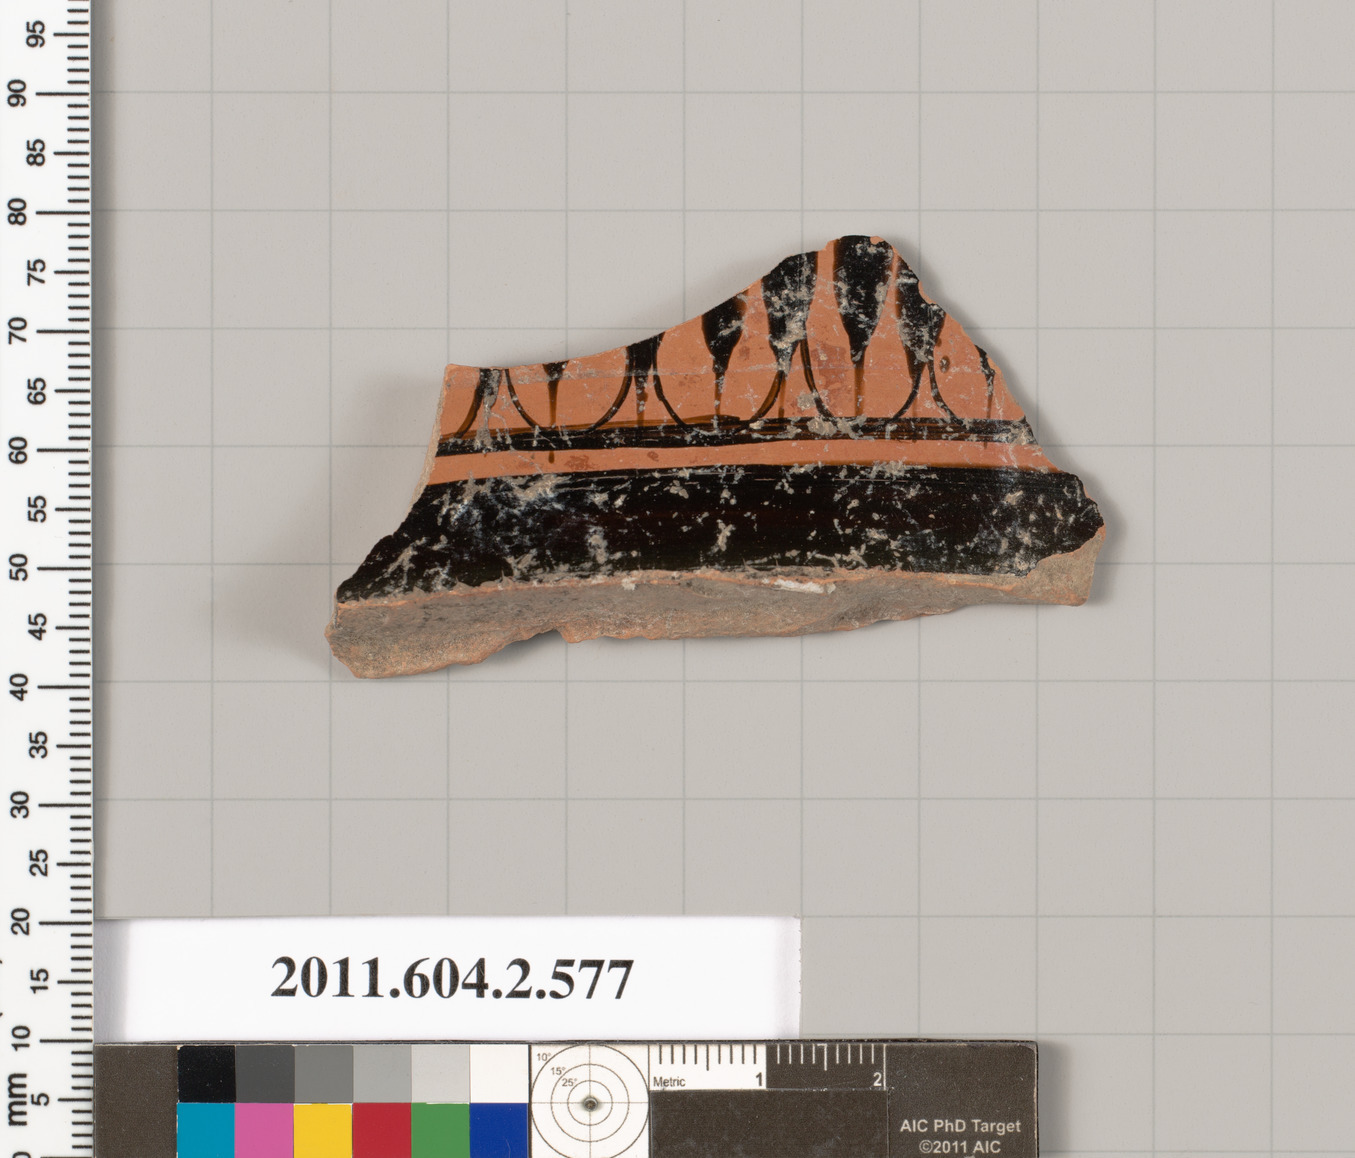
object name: column krater fragment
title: Terracotta fragment of a column-krater (bowl for mixing wine and water)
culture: greek, attic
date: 460-440 BCE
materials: terracotta